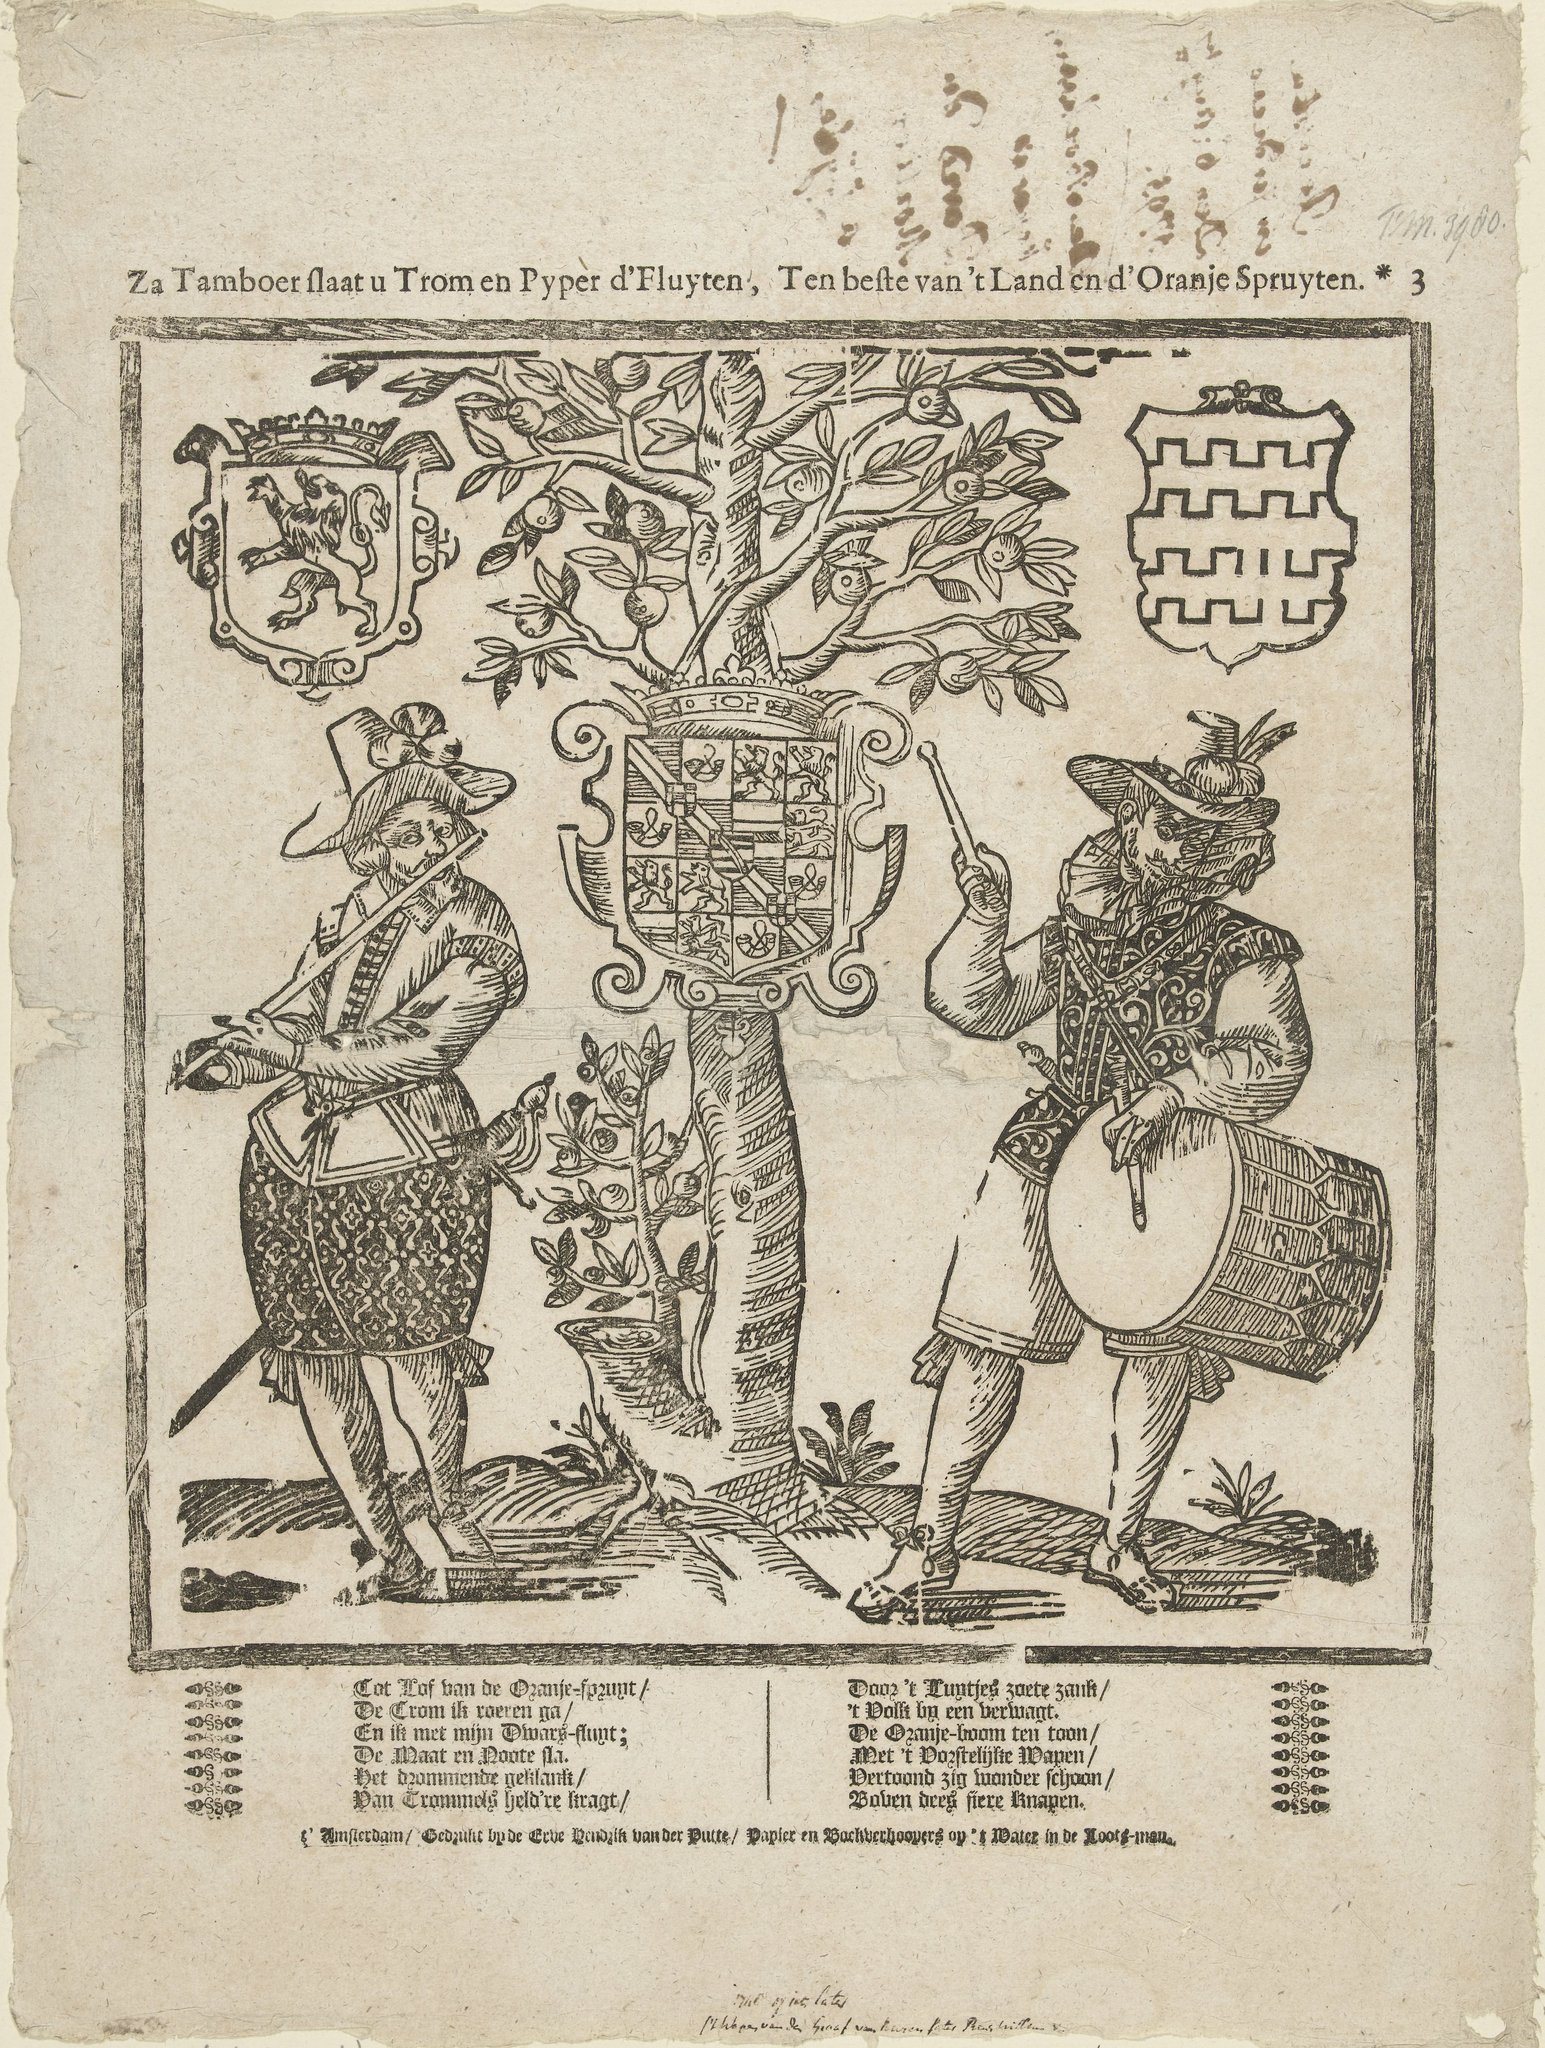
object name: print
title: Za tamboer slaat u trom en pyper d'fluyten, Ten beste van 't land en d'Oranje spruyten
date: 1605-1615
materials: paper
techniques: letterpress printing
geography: amsterdam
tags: the hague, william v (prince of orange), maurice (prince of orange), military music, transverse flute, drum (musical instrument)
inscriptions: inscription: ‘[...] later / 't wapen van de Graaf van Buren [...] Prins Maurits V.’, inscription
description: Blad met een grote voorstelling van een tamboer en een fluitspeler, staande aan weerszijden van de spruitende oranjeboom waaraan het wapen van prins Maurits hangt. Bovenaan ook de wapens van Holland en Buren. Onder de voorstelling twee zesregelige verzen in twee kolommen. Genummerd rechtsboven: *3. Mogelijk ter gelegenheid van de geboorte van prins Willem V in 1748.